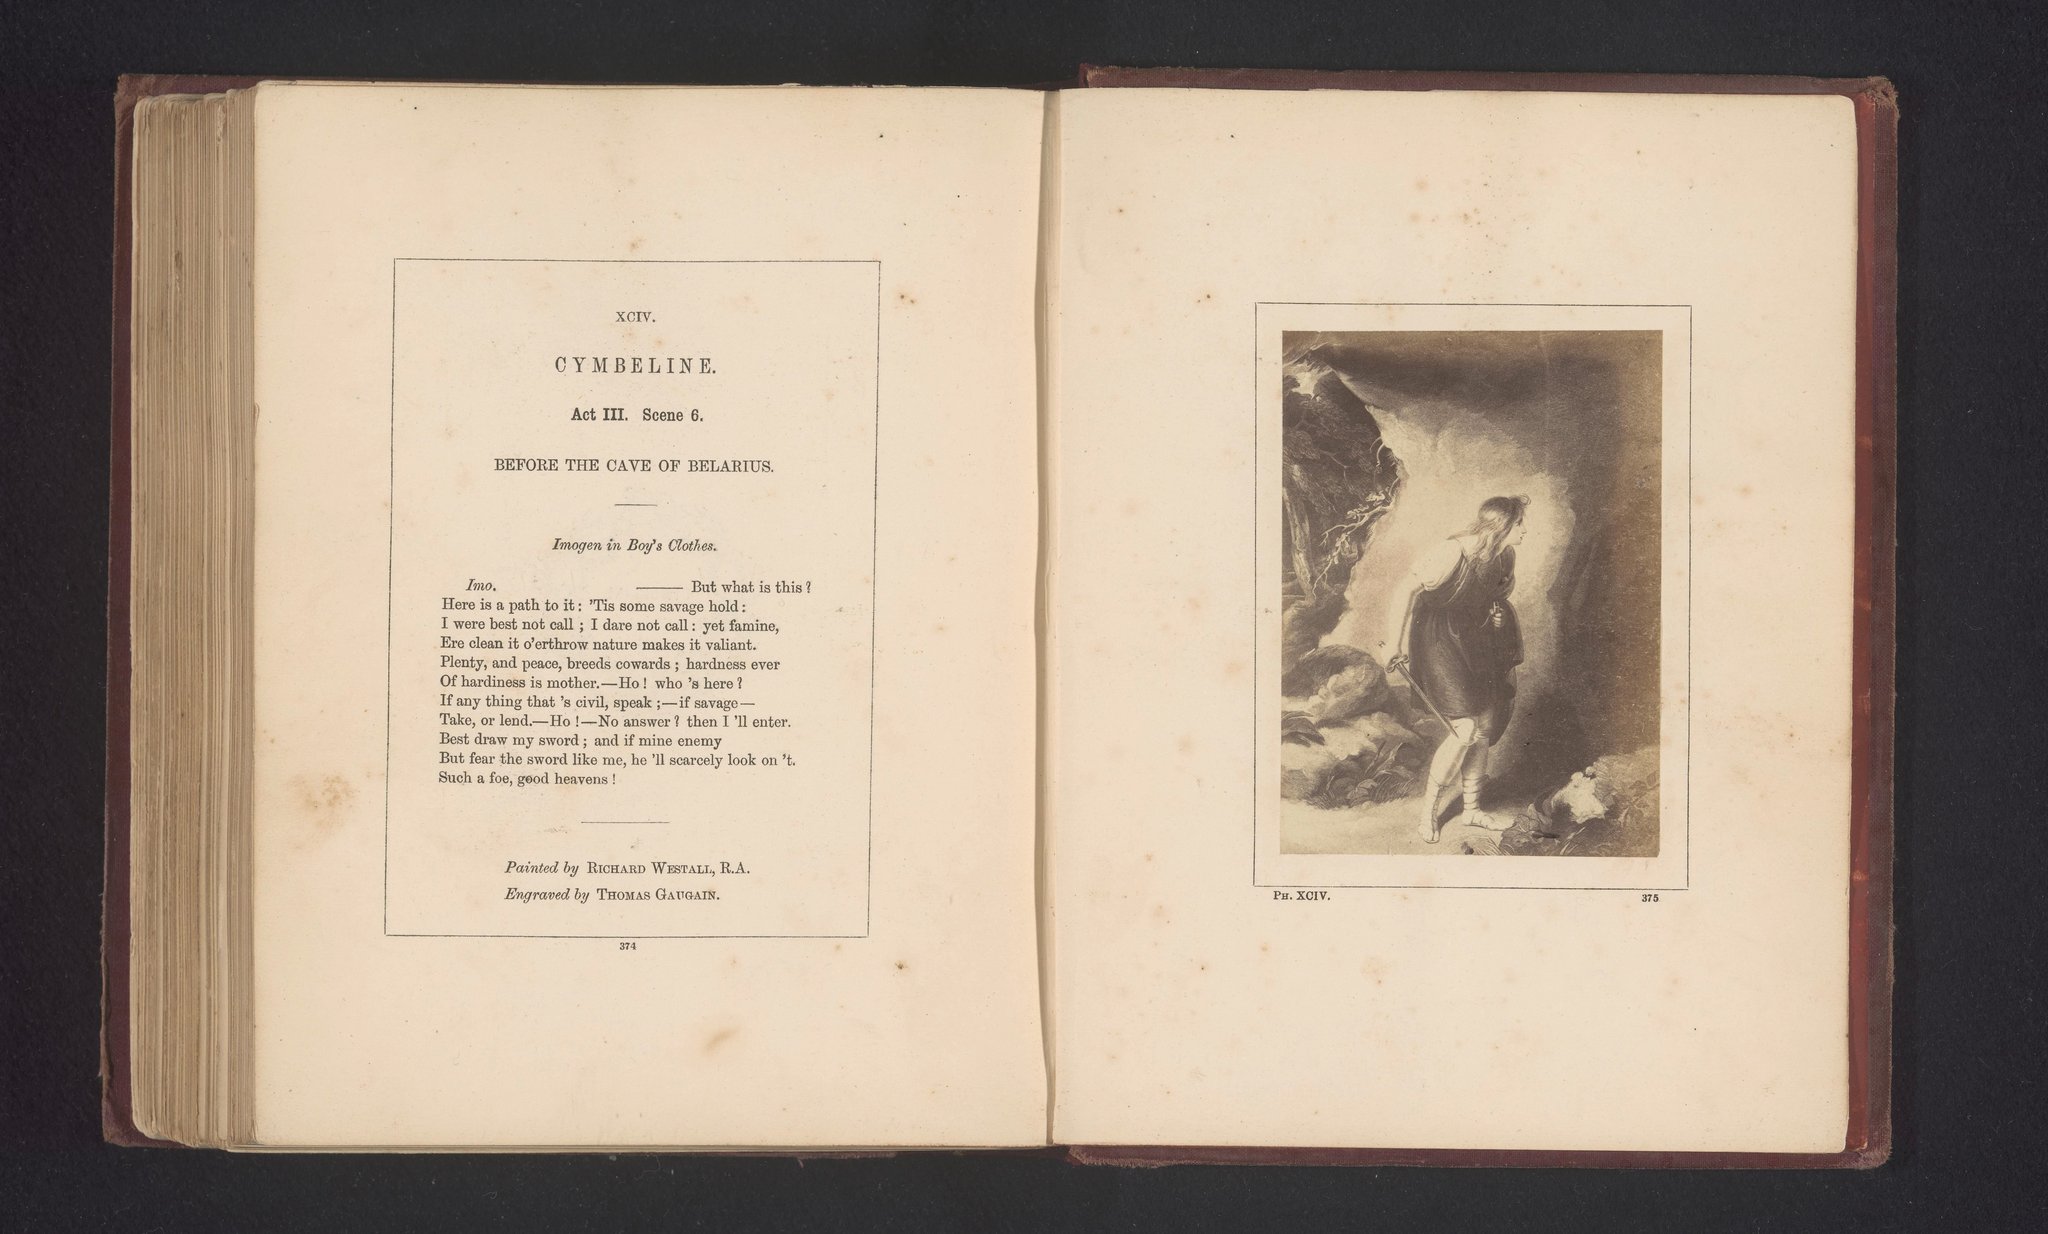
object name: page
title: Fotoreproductie van een prent naar een schilderij door Richard Westall, voorstellend een scene uit Cymbeline door William Shakespeare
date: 1854-1867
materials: photographic support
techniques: albumen print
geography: london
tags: (scenes from) specific works of literature: shakespeare, cymbeline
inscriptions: number: ‘Ph. XCIV. 375’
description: Te zien is akte III, scene 6 met Imogen in jongenskleren.